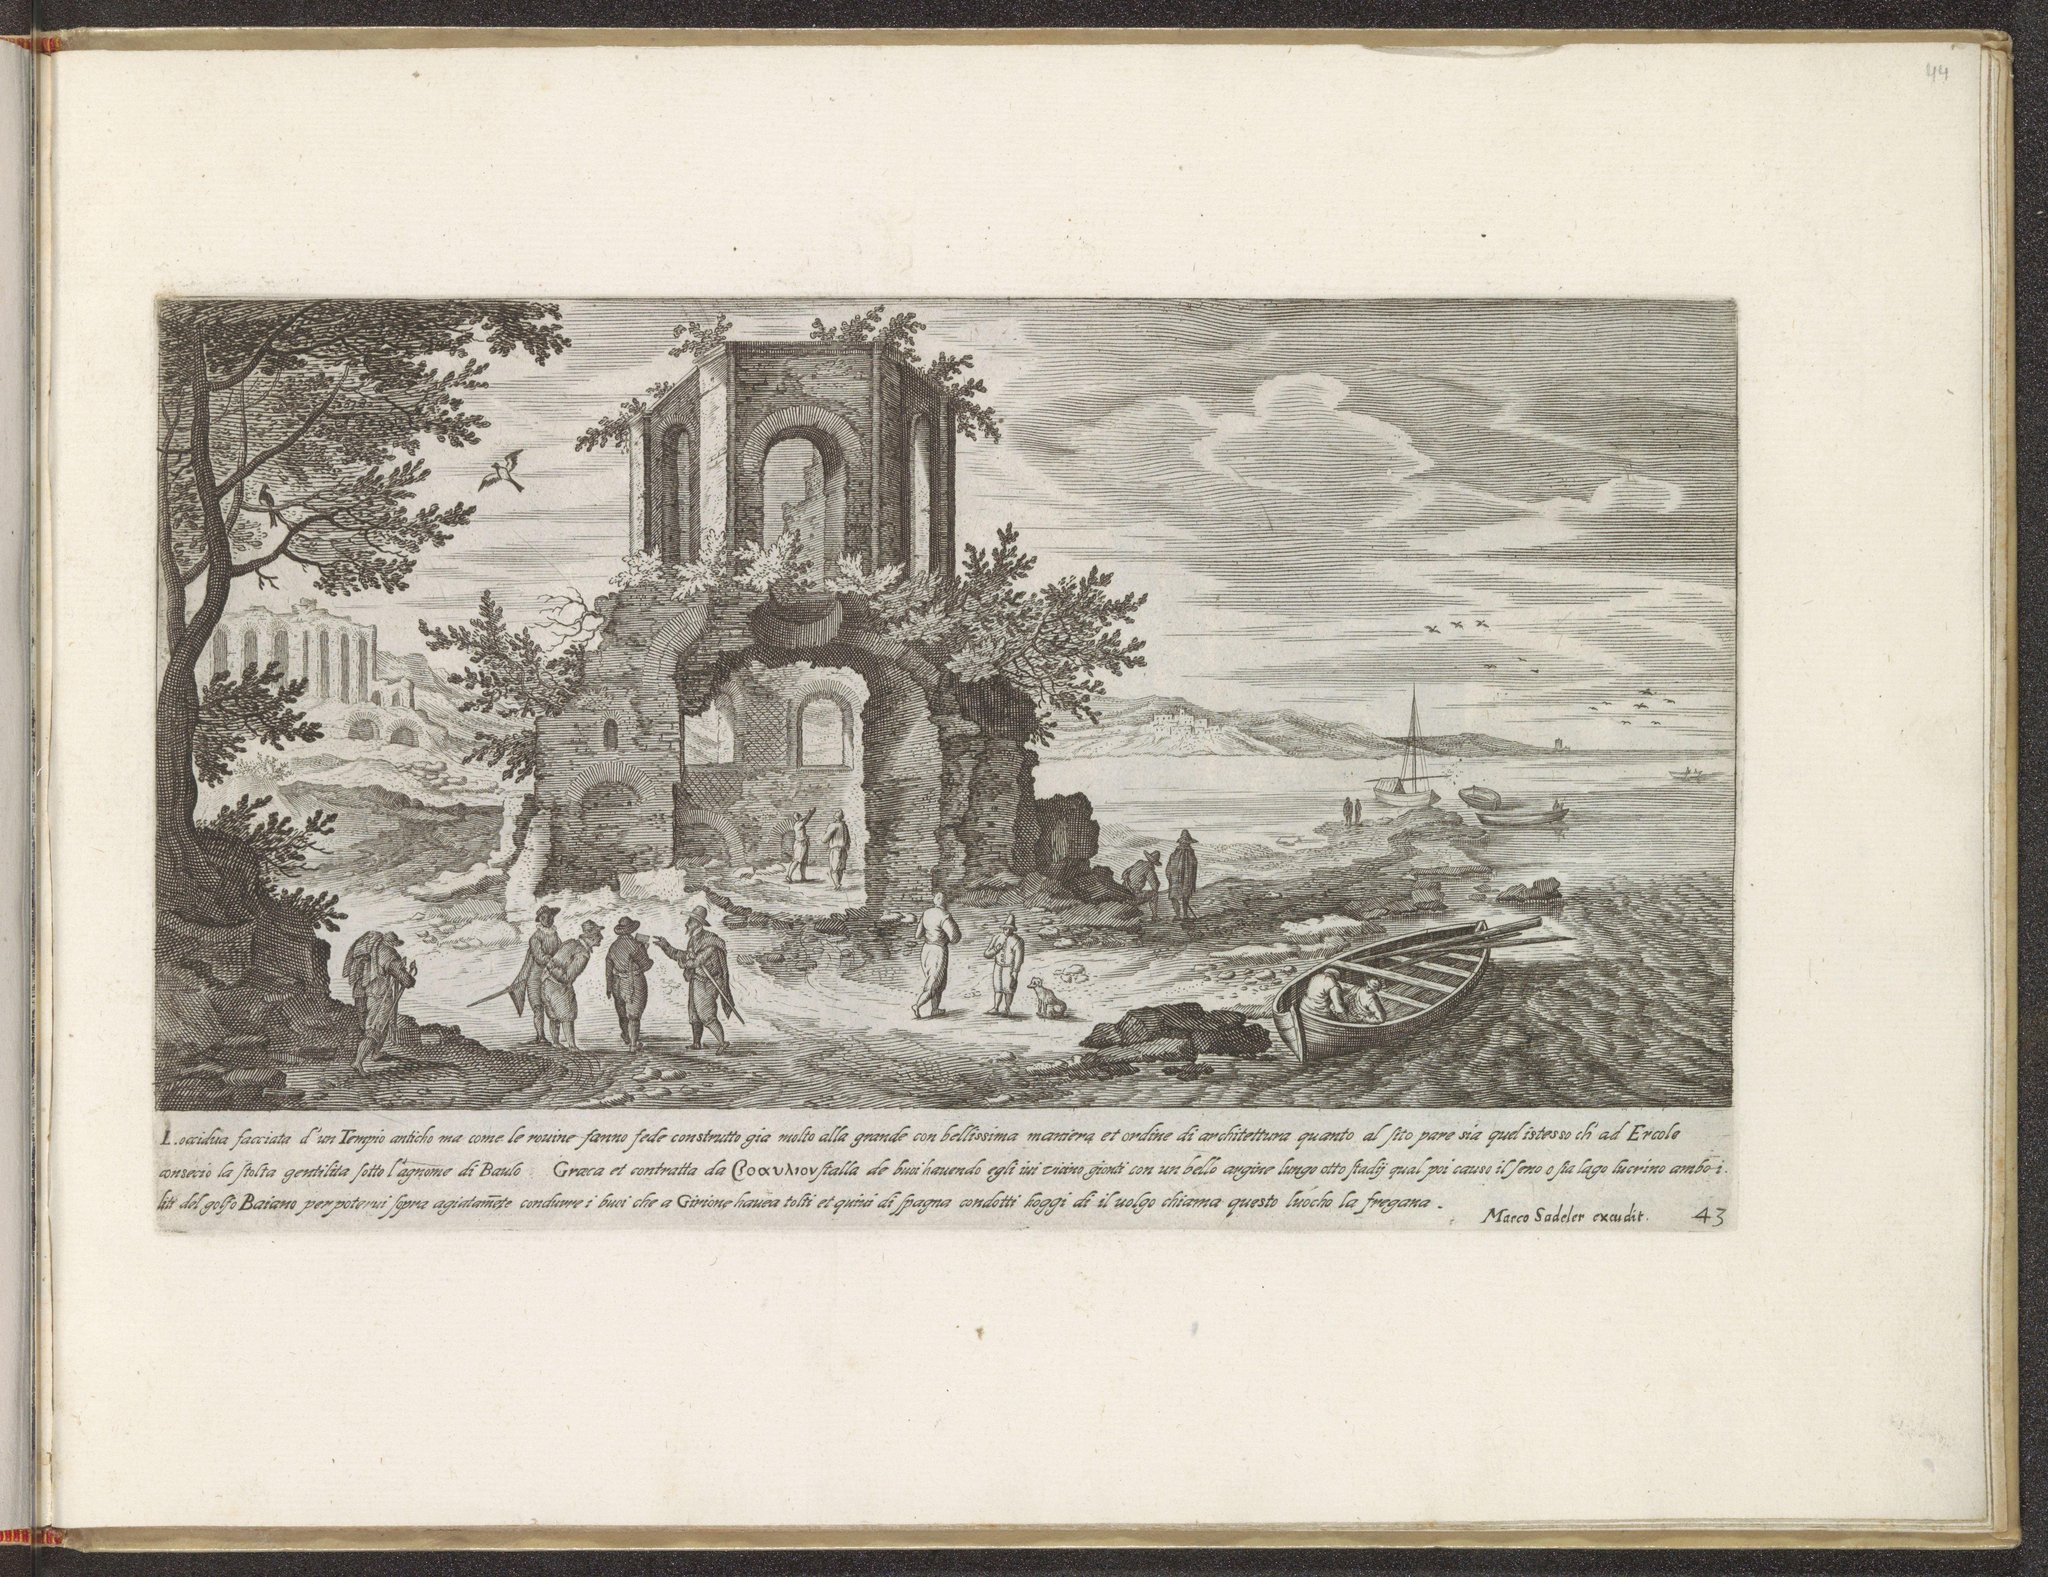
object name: album leaf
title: Tempel van Venus of Diana bij Baia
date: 1606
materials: paper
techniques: engraving, etching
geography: prague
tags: baia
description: De overblijfselen van de tempel van Venus of Diana bij Baia, gelegen aan de kust. Op de voorgrond verschillende figuren en enkele boten. In de ondermarge drie regels tekst in het Italiaans. De prent maakt deel uit van een album.